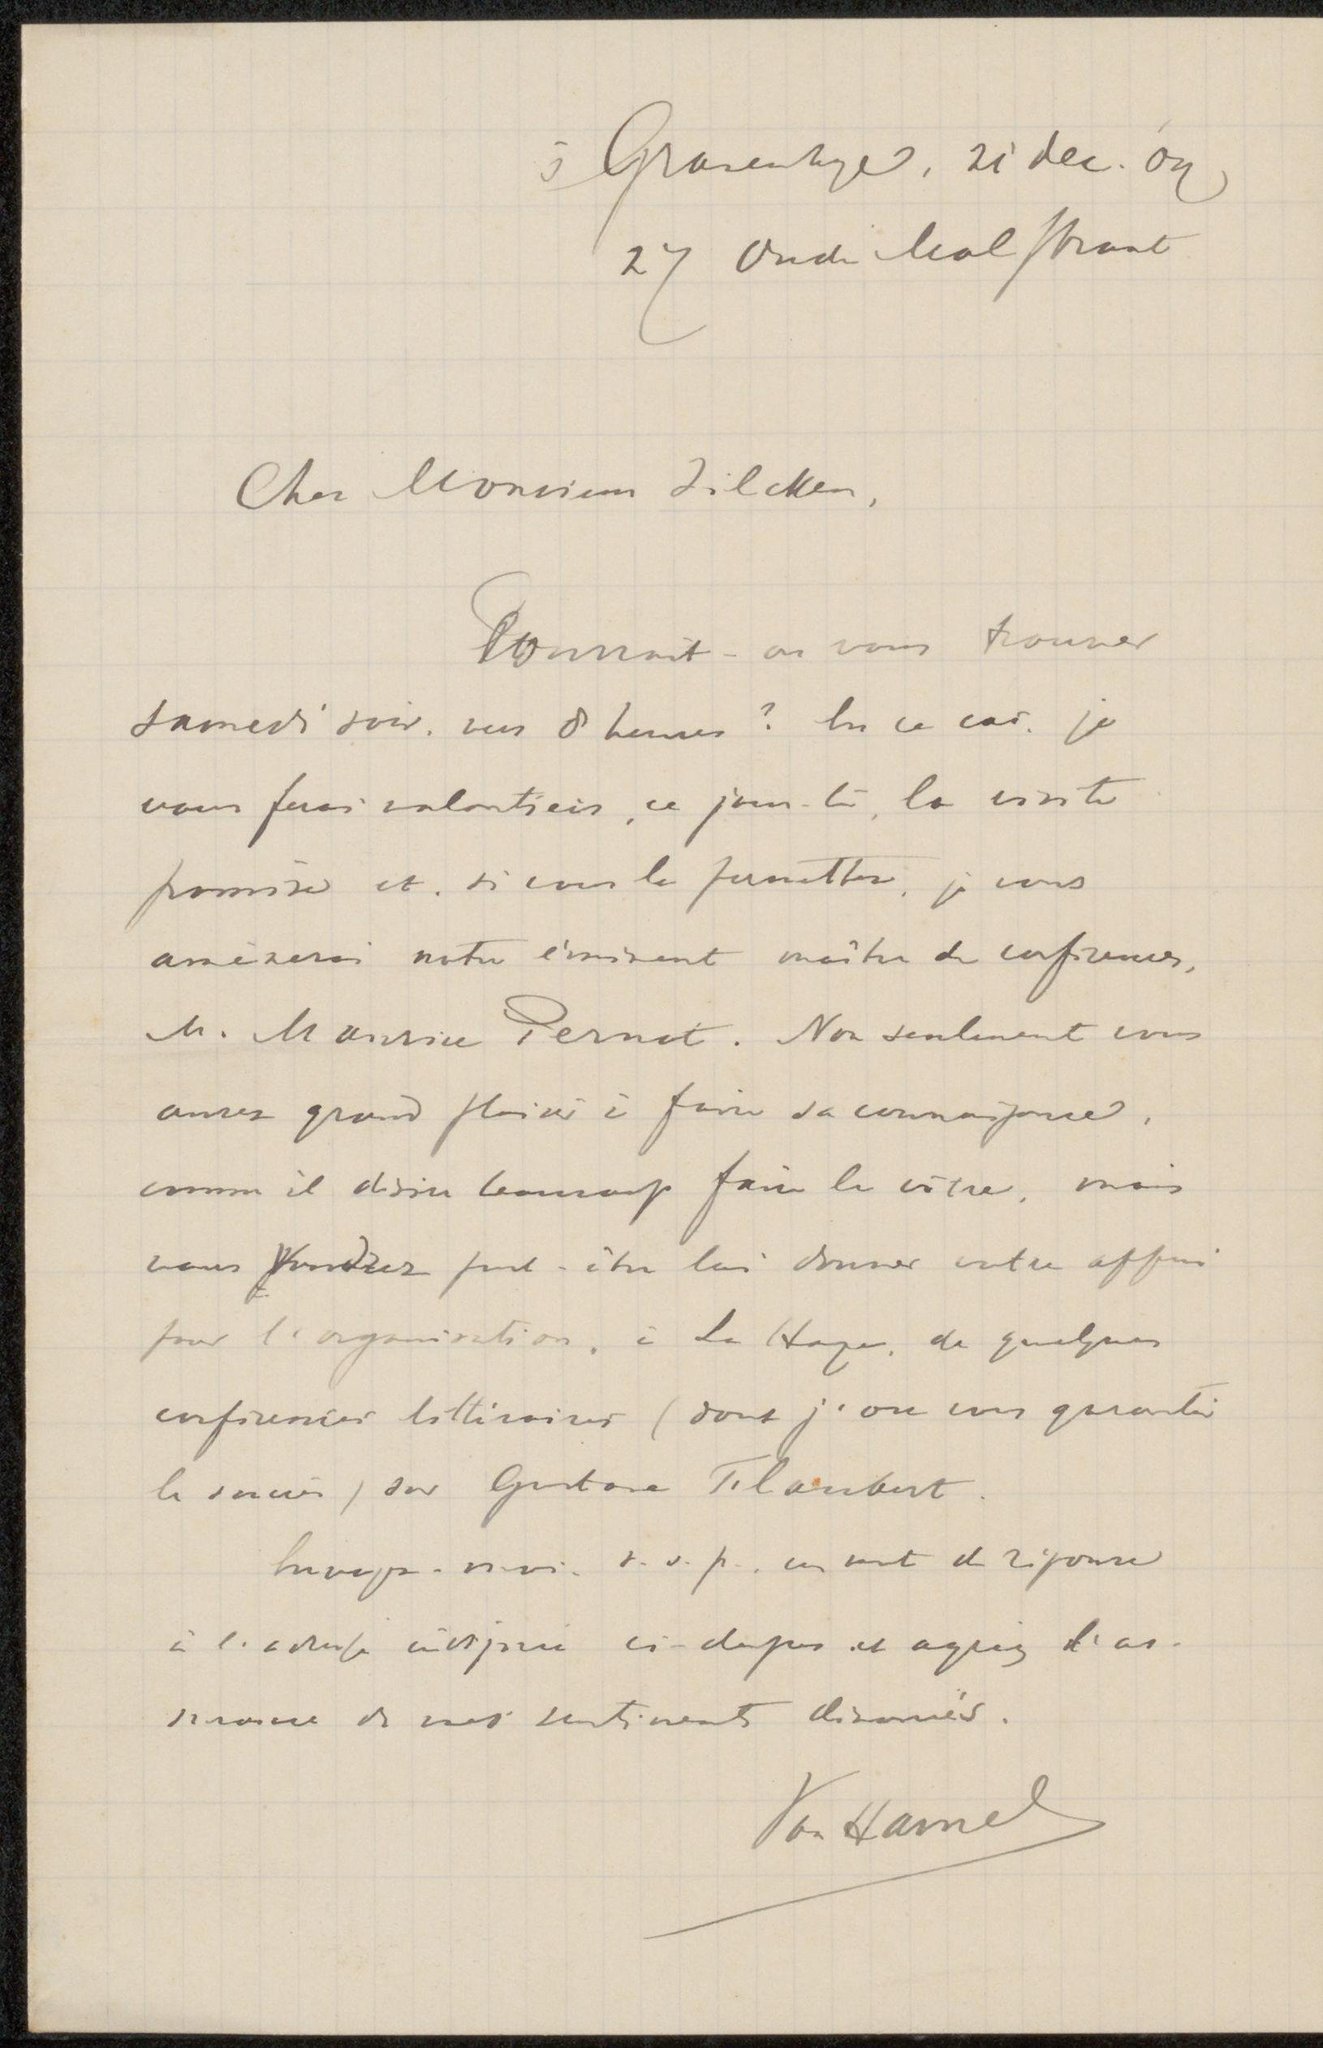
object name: letter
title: Brief aan Philip Zilcken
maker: antonius gerardus van hamel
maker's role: hoogleraar, theoloog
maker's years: 1842-1907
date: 1904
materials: ink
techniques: pen, writing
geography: the hague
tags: gustave flaubert, maurice pernot, painter, draughtsman, philip zilcken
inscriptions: collector's mark: ‘RPK’